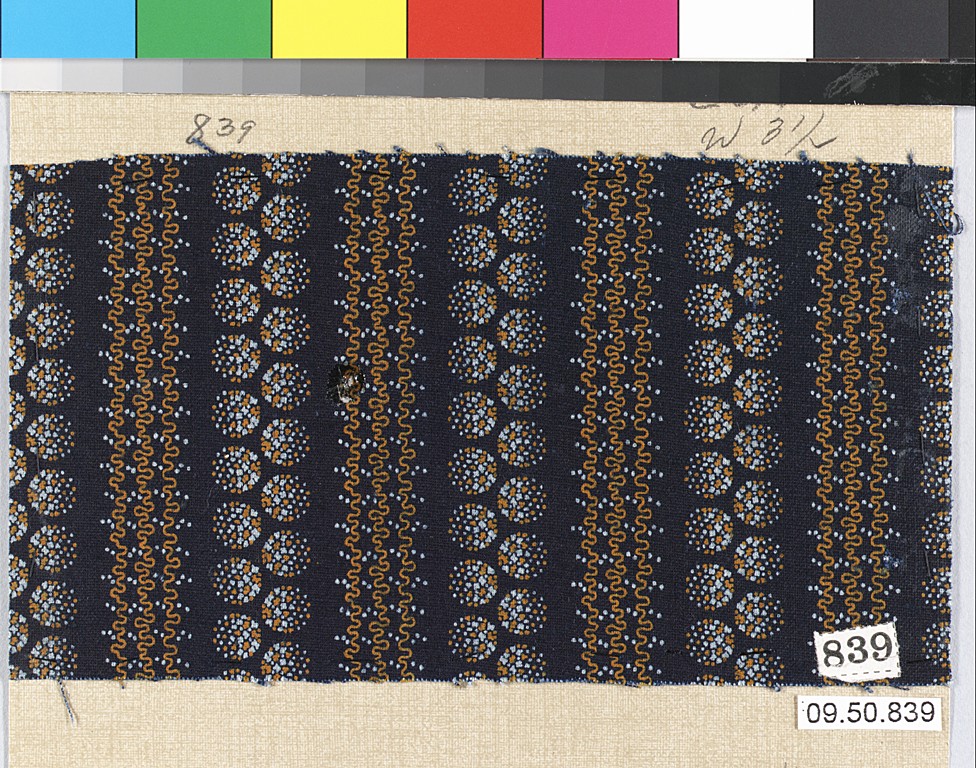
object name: piece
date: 1801-1900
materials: cotton